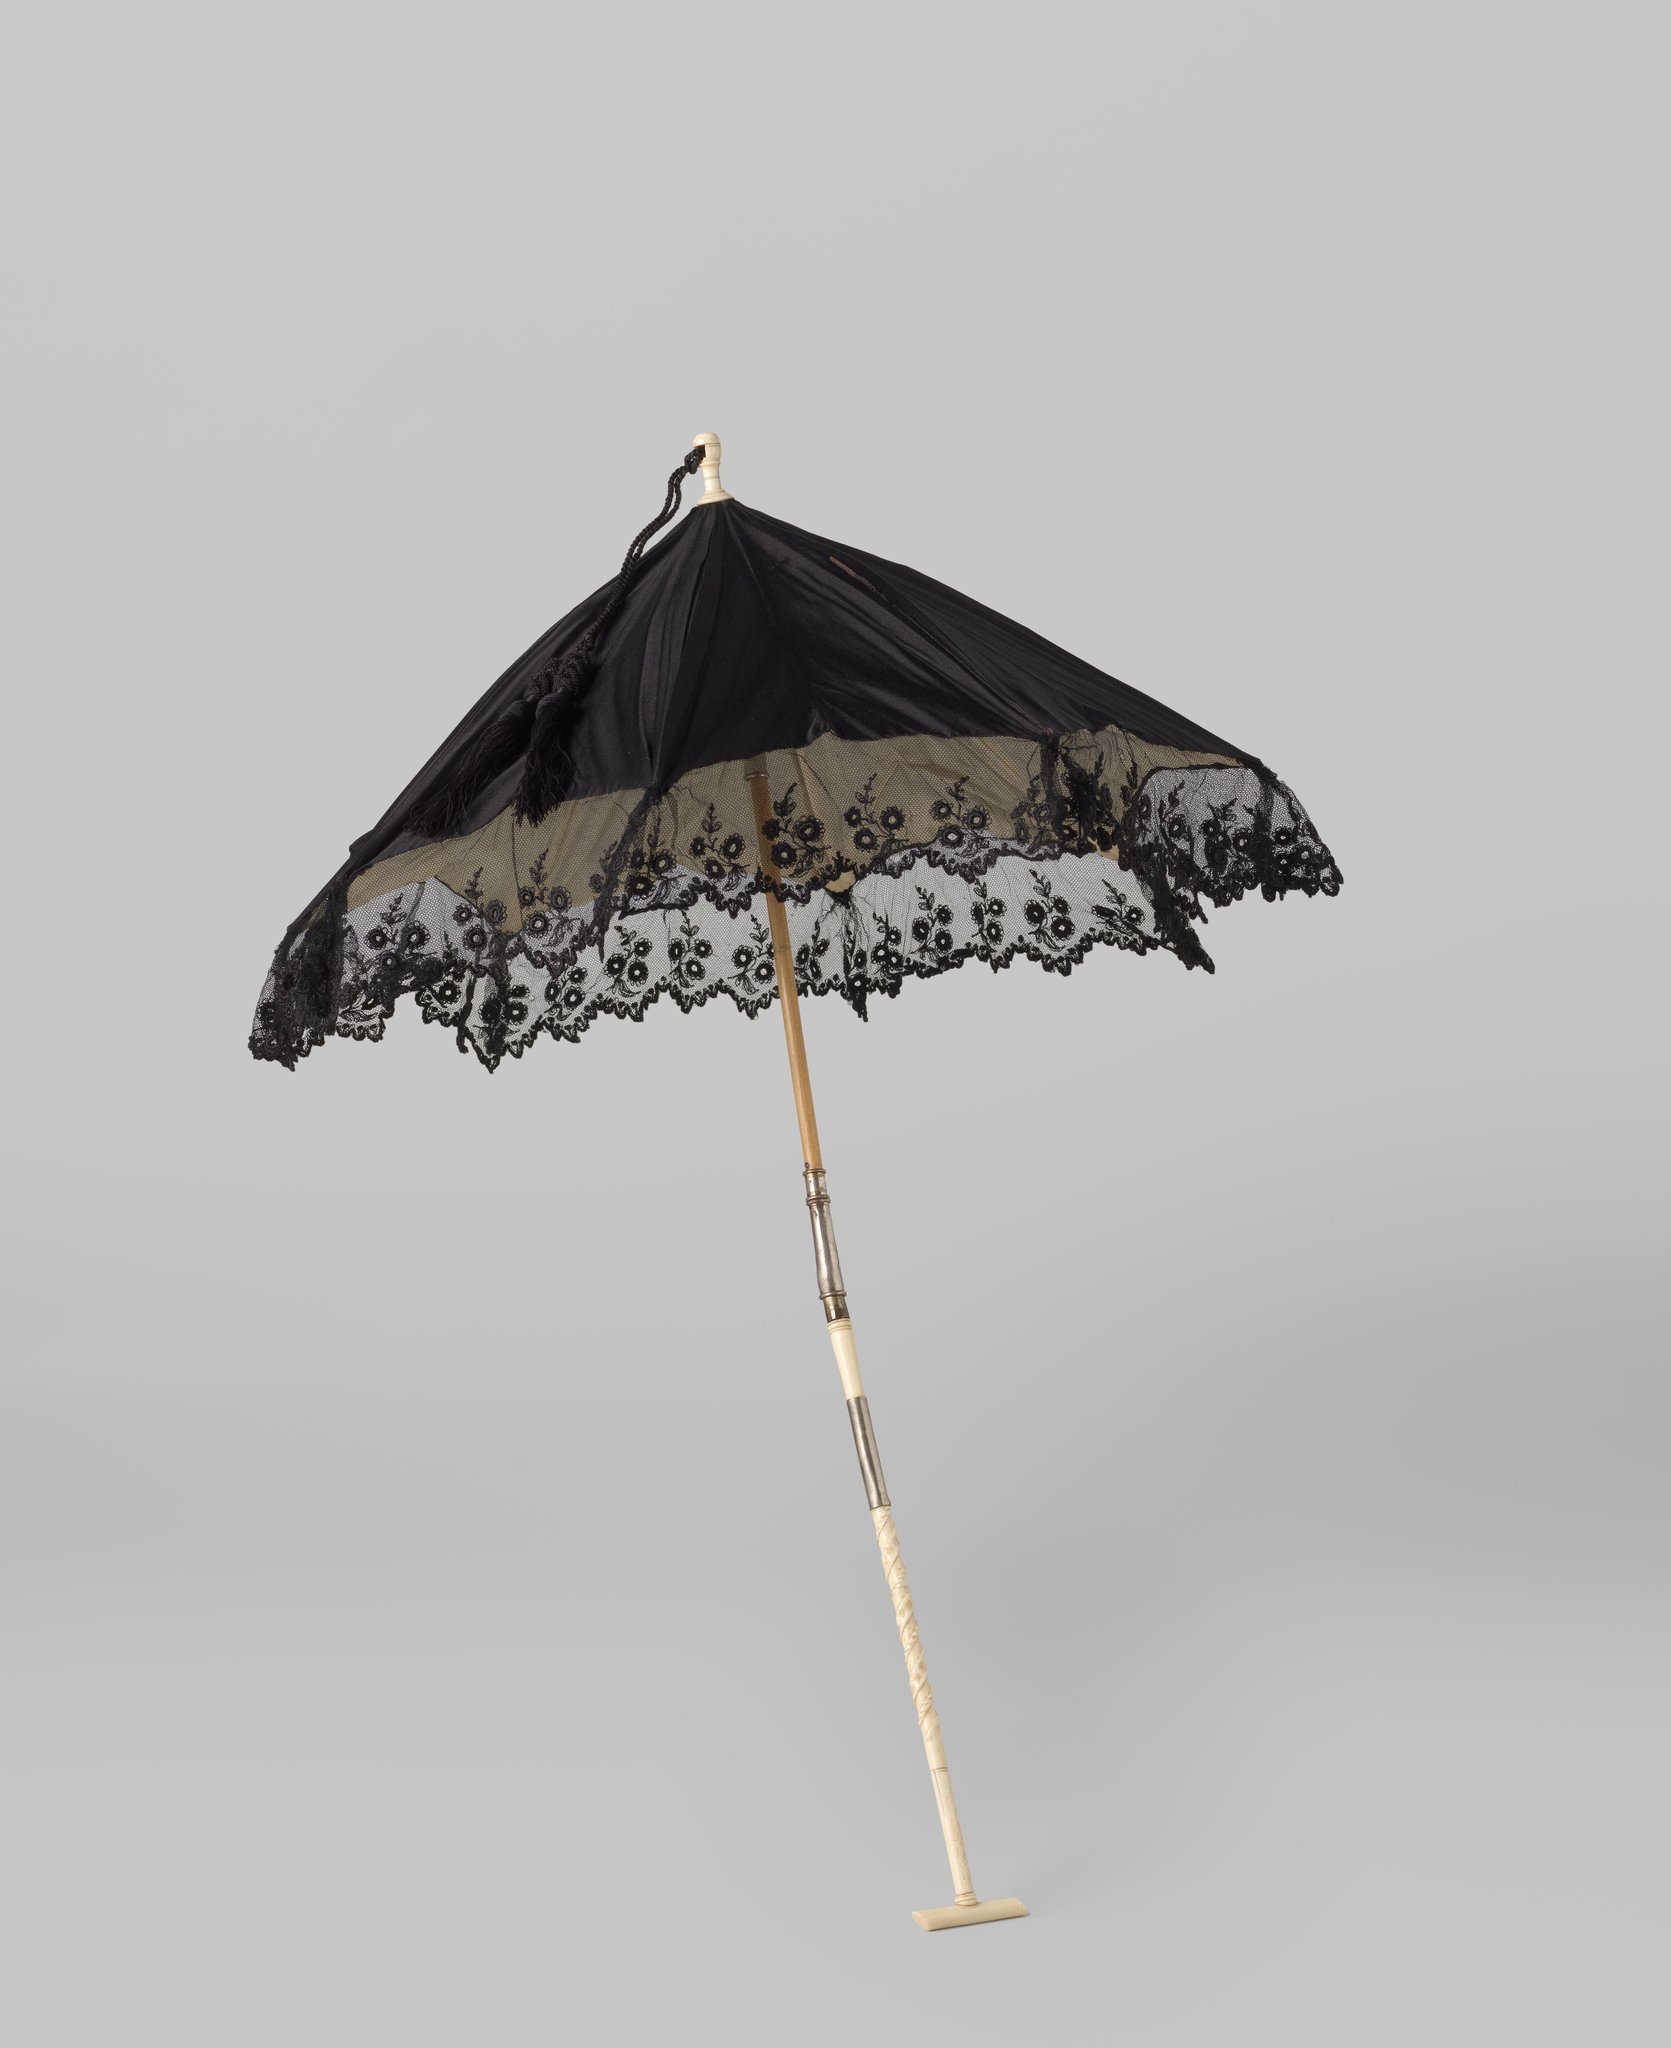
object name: carriage parasol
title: Rijtuigparasol met dek van zwart satijn, waarlangs een strook zwarte tule waarop machinaal borduurwerk en een stok van ivoor met een T-vormig handvat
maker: Anonymous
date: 1840-1870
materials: cotton, ivory, lacquer, metal, silk, wood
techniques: casting, cutting, embroidered, lacquer, weave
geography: france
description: Rijtuigparasol met dek van onversierde zwarte satijn, waarlangs een strook zwarte tule waarop machinaal borduurwerk. Voering van effen witte ponjé-zijde. De stok is van ivoor, met in reliëf twee spiraalvormige banden. Het handvat eindigt in een T-vorm. Halverwege de stok meerdere metalen ringen, waarvan er één omhoog geschoven kan worden, waardoor de stok kan knikken. Het bovenste deel van de stok is van gelakt hout. Bovenop een eikelvormige knop, met door het gat een katoenen koord, waaraan twee dito kwasten.